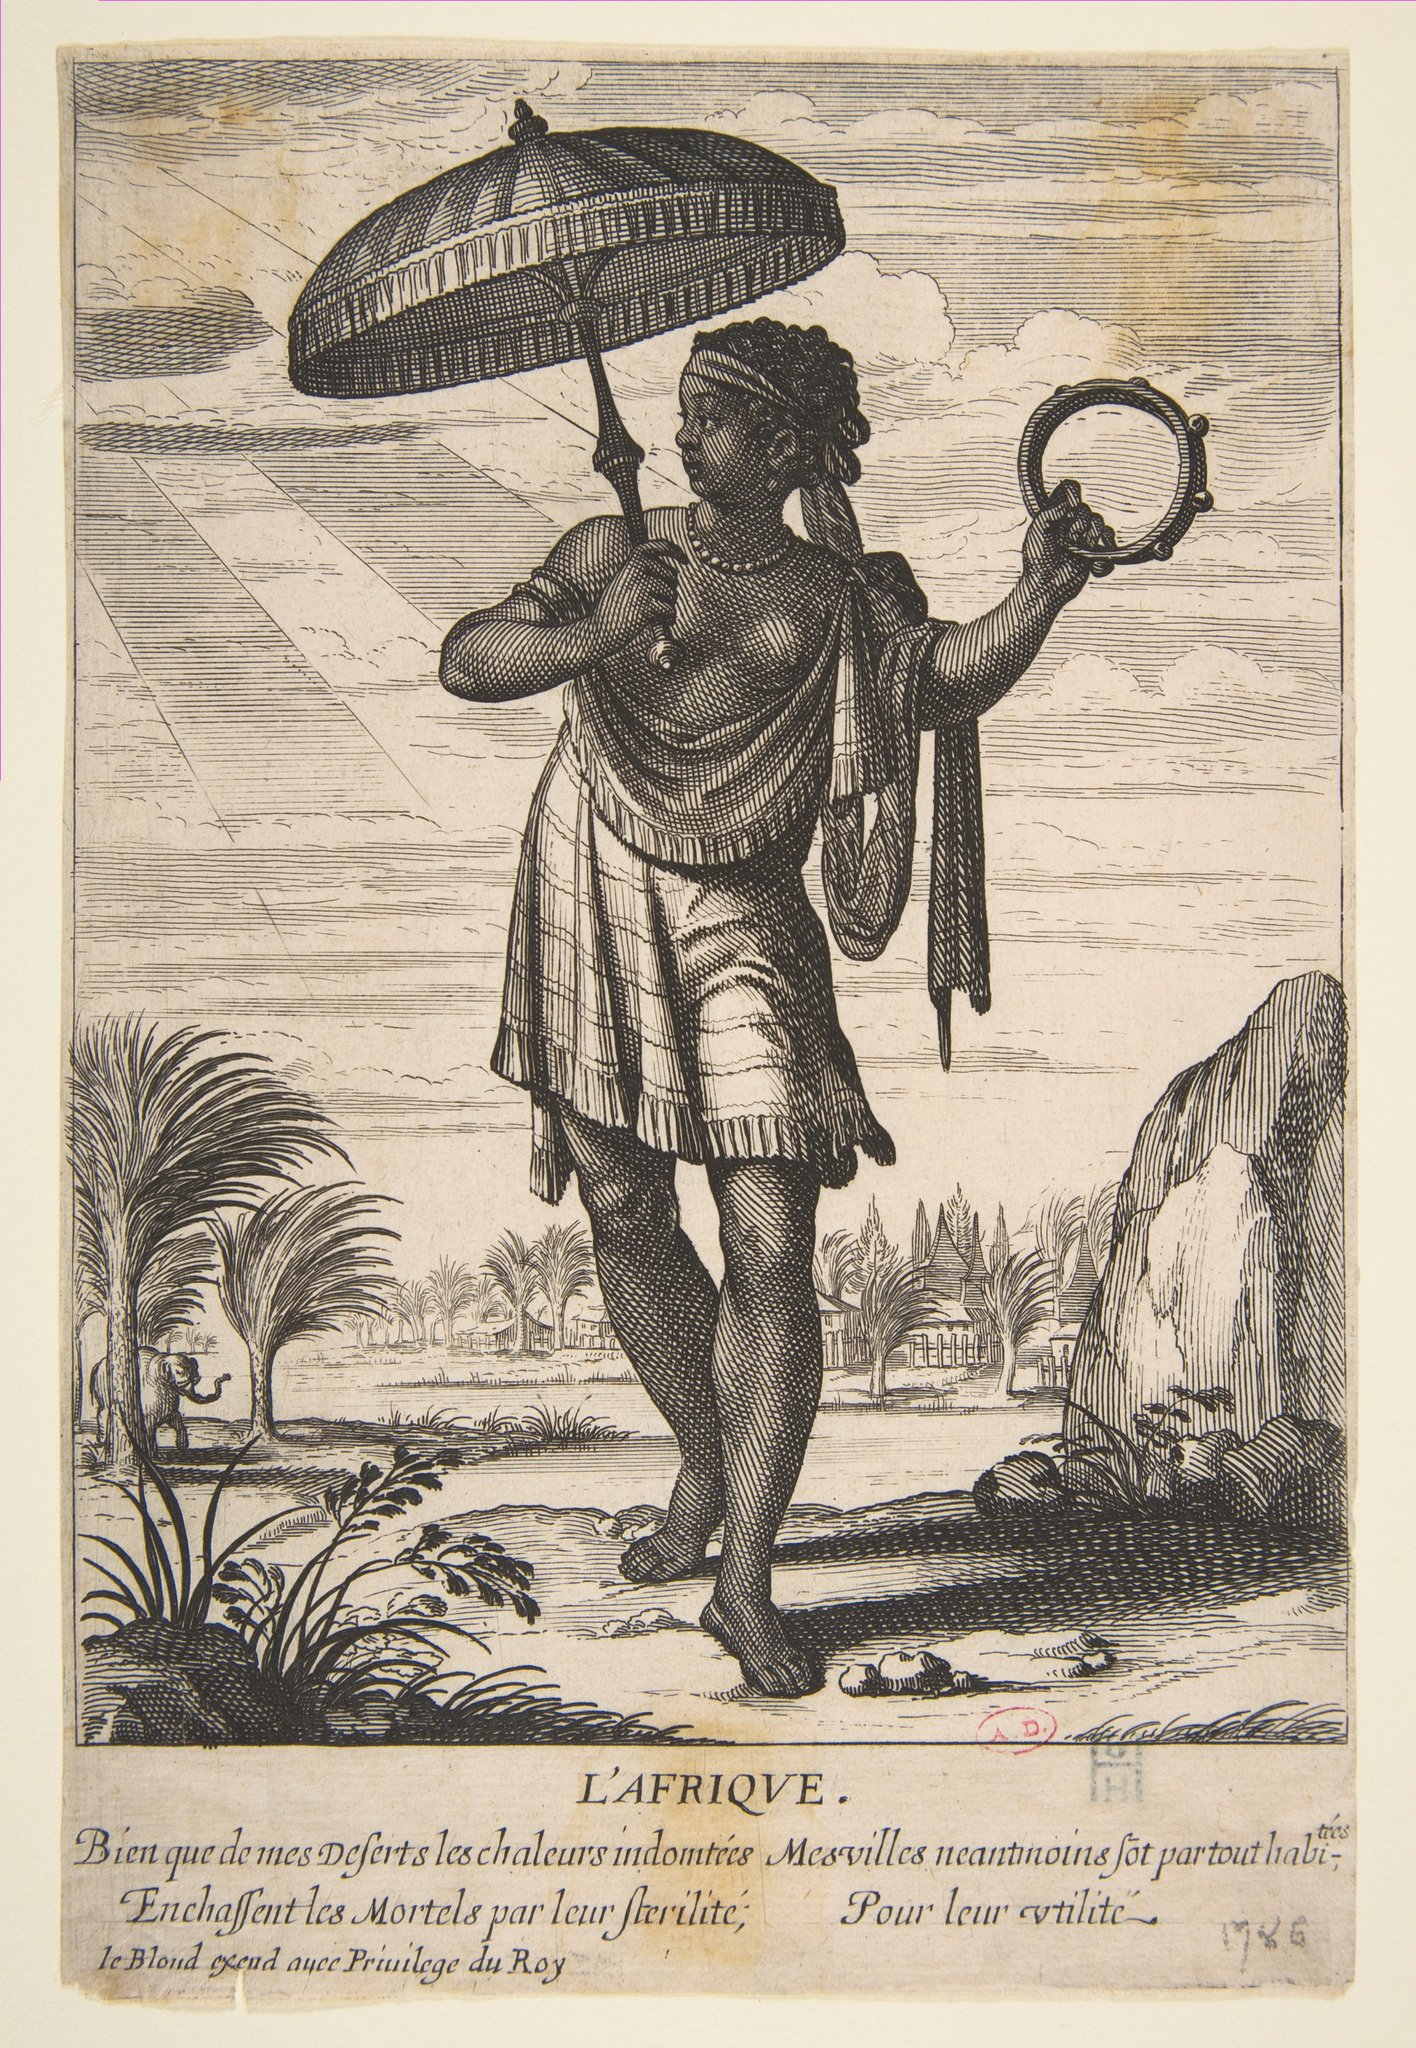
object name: print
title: Allegory of Africa, from "The Four Continents"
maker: abraham bosse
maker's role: artist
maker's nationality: french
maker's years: 1602-1676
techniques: etching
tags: musical instruments,women,umbrellas